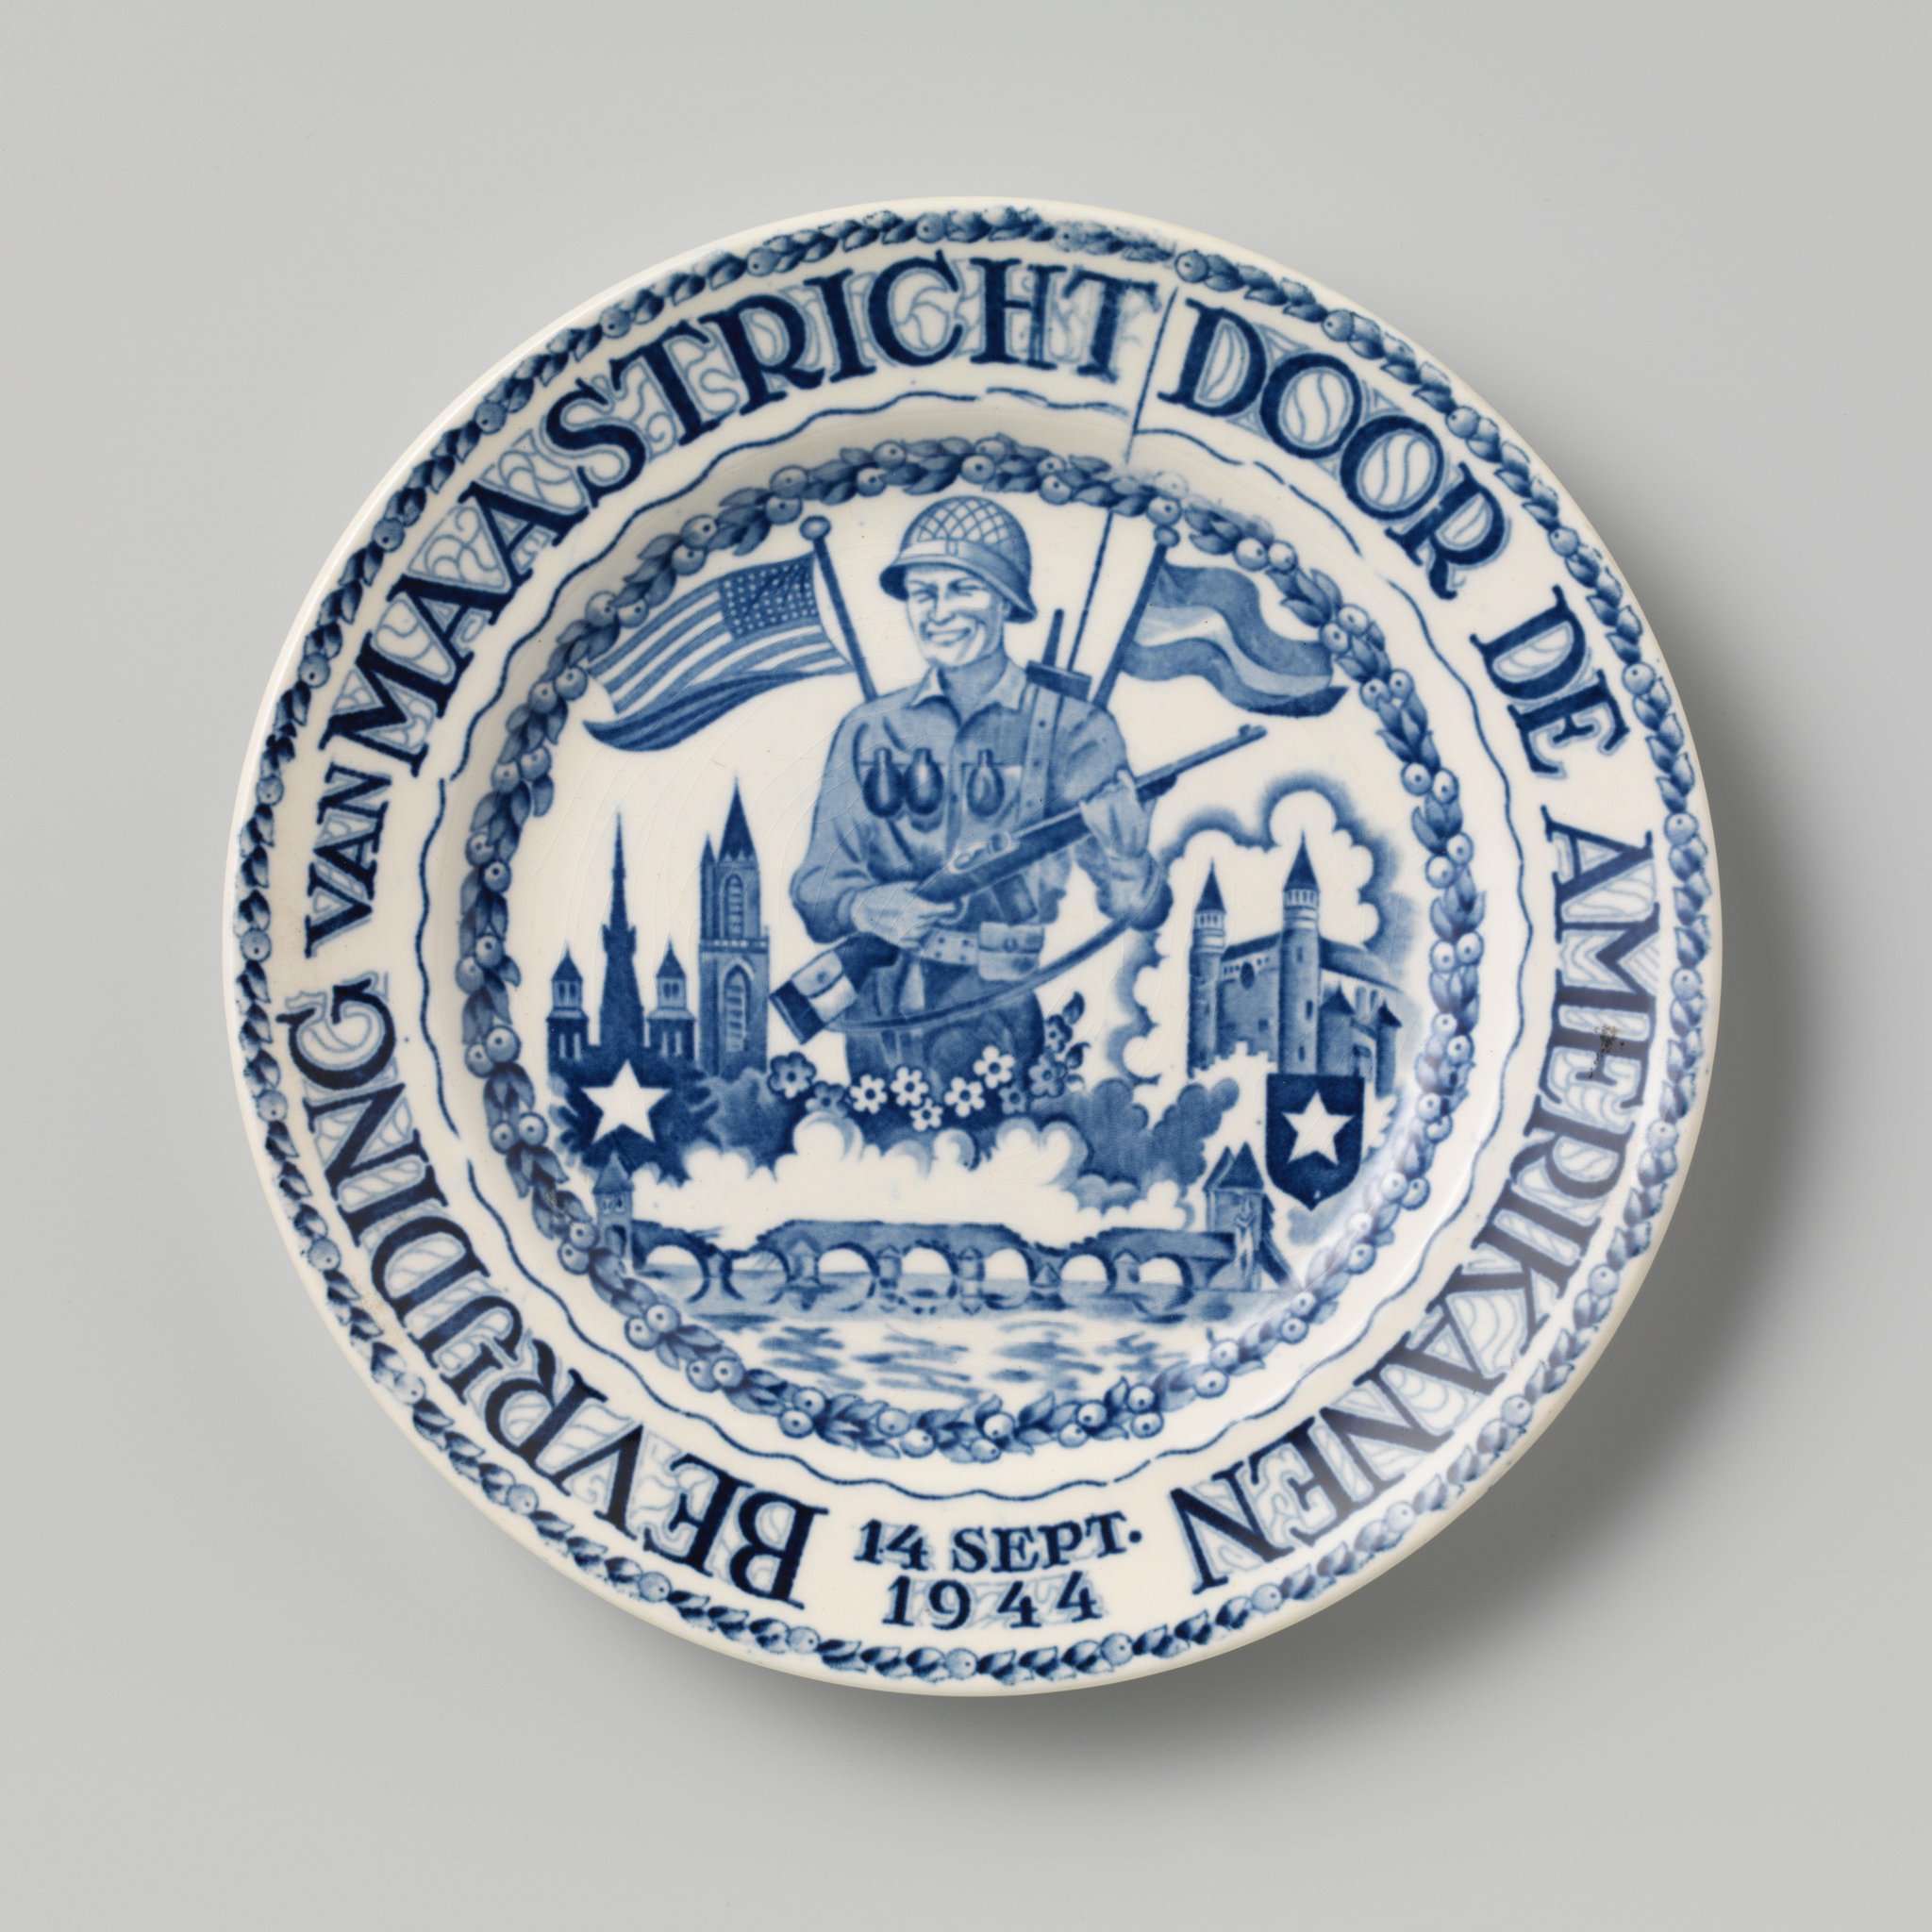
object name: plate dish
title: Bevrijding van Maastricht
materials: earthenware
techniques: firing, vitrification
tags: the soldier; the soldier's life, maastricht